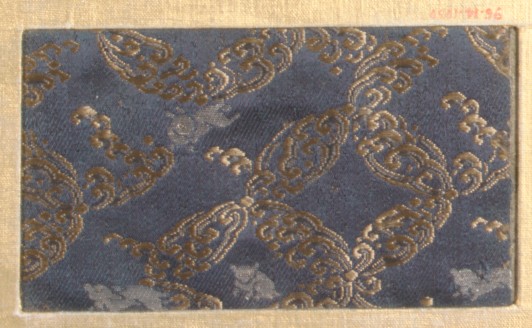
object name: piece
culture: japanese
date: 1701-1900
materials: silk